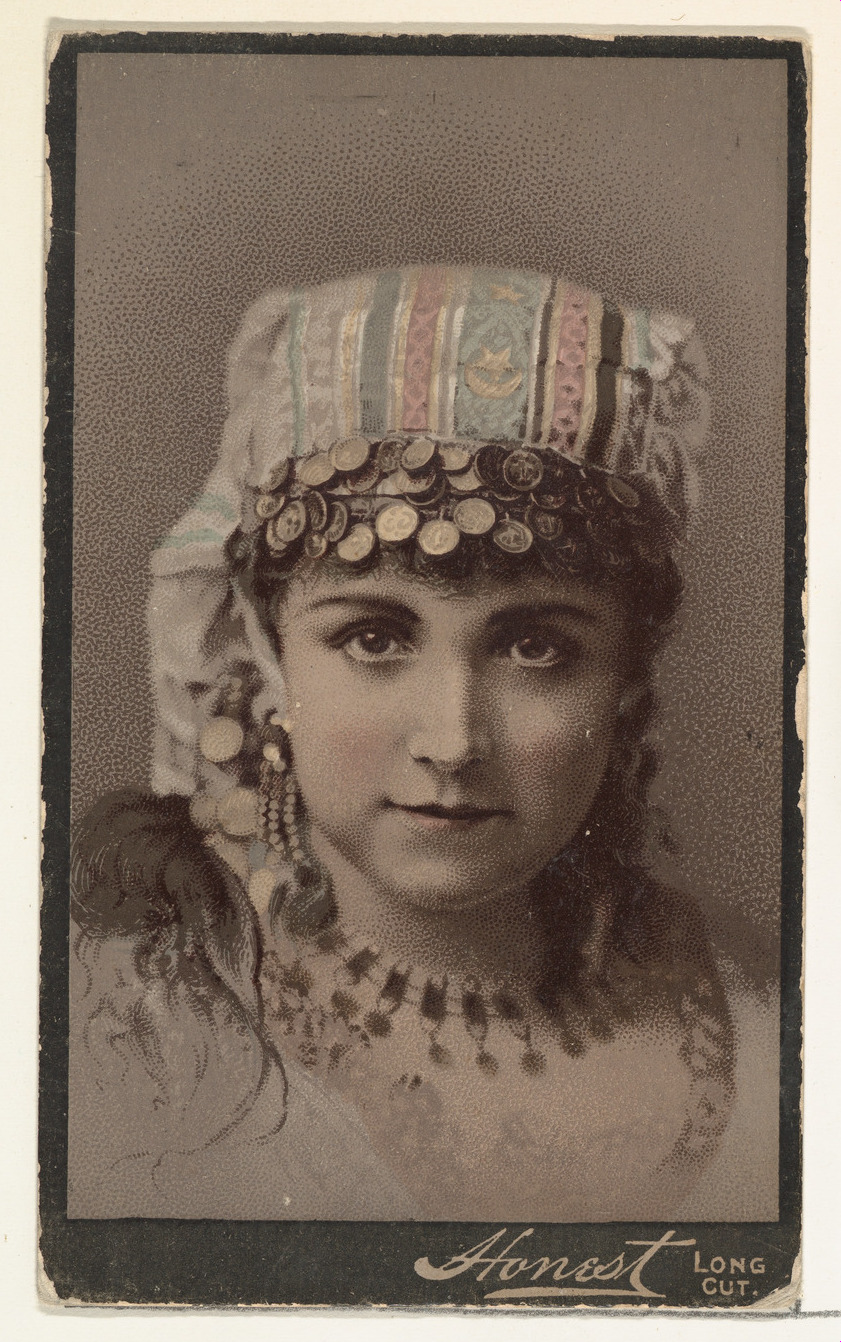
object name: print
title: Actress wearing ornate cloth headpiece decorated with dangling coins, from Stars of the Stage, Third Series (N131) issued by Duke Sons & Co. to promote Honest Long Cut Tobacco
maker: w. duke, sons & co.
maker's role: publisher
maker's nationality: american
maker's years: 1870-1920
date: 1891-1892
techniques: color lithograph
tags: portraits,women,actresses